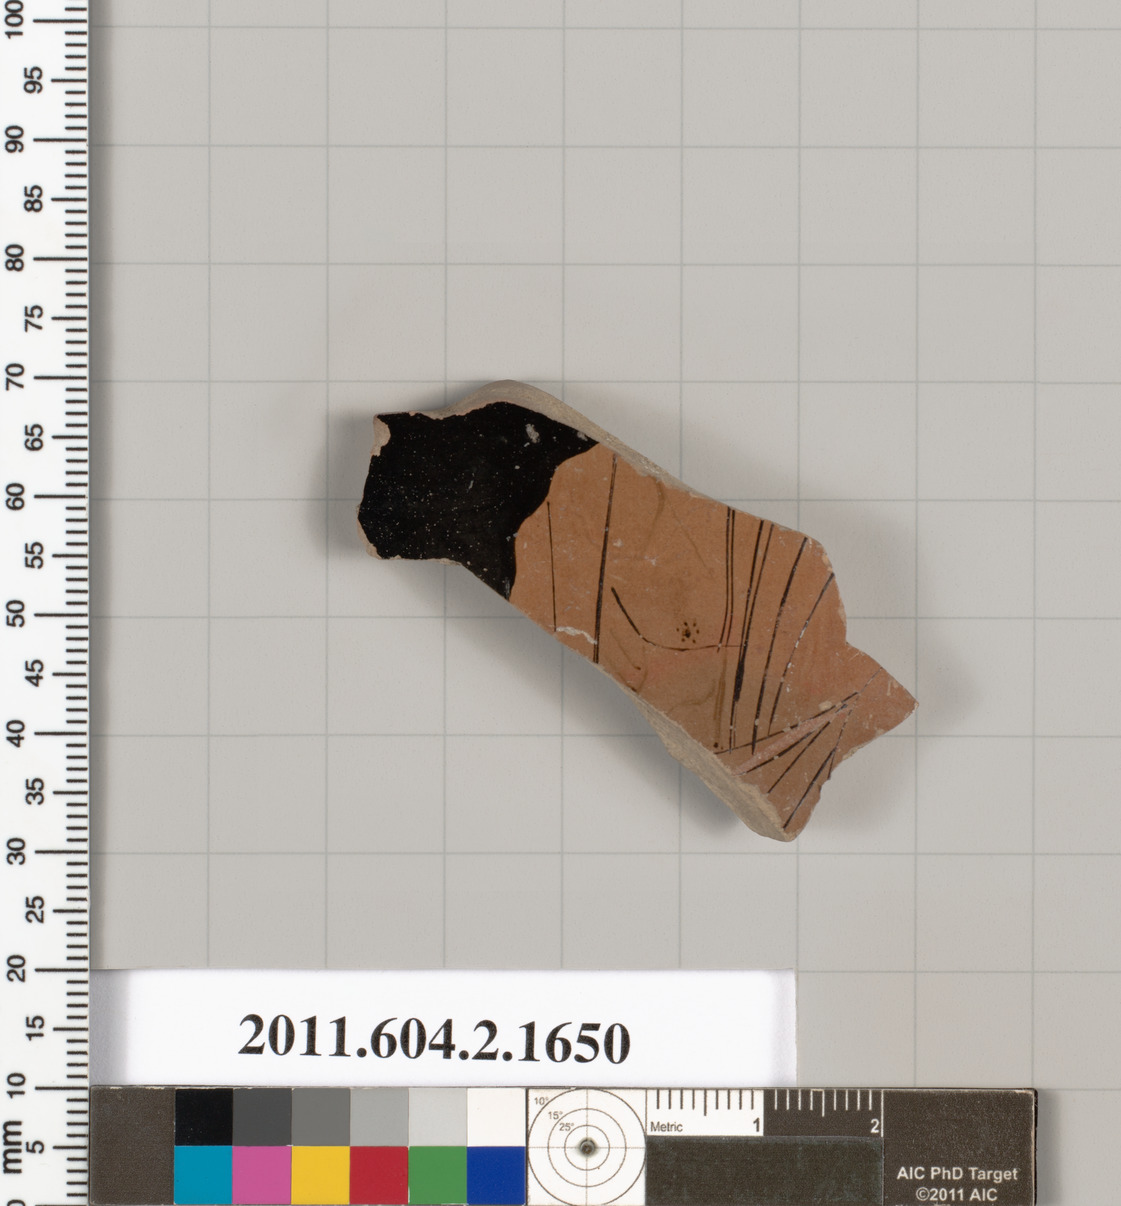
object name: skyphos fragment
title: Terracotta fragment of a skyphos (deep drinking cup)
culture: greek, attic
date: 450-426 BCE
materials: terracotta